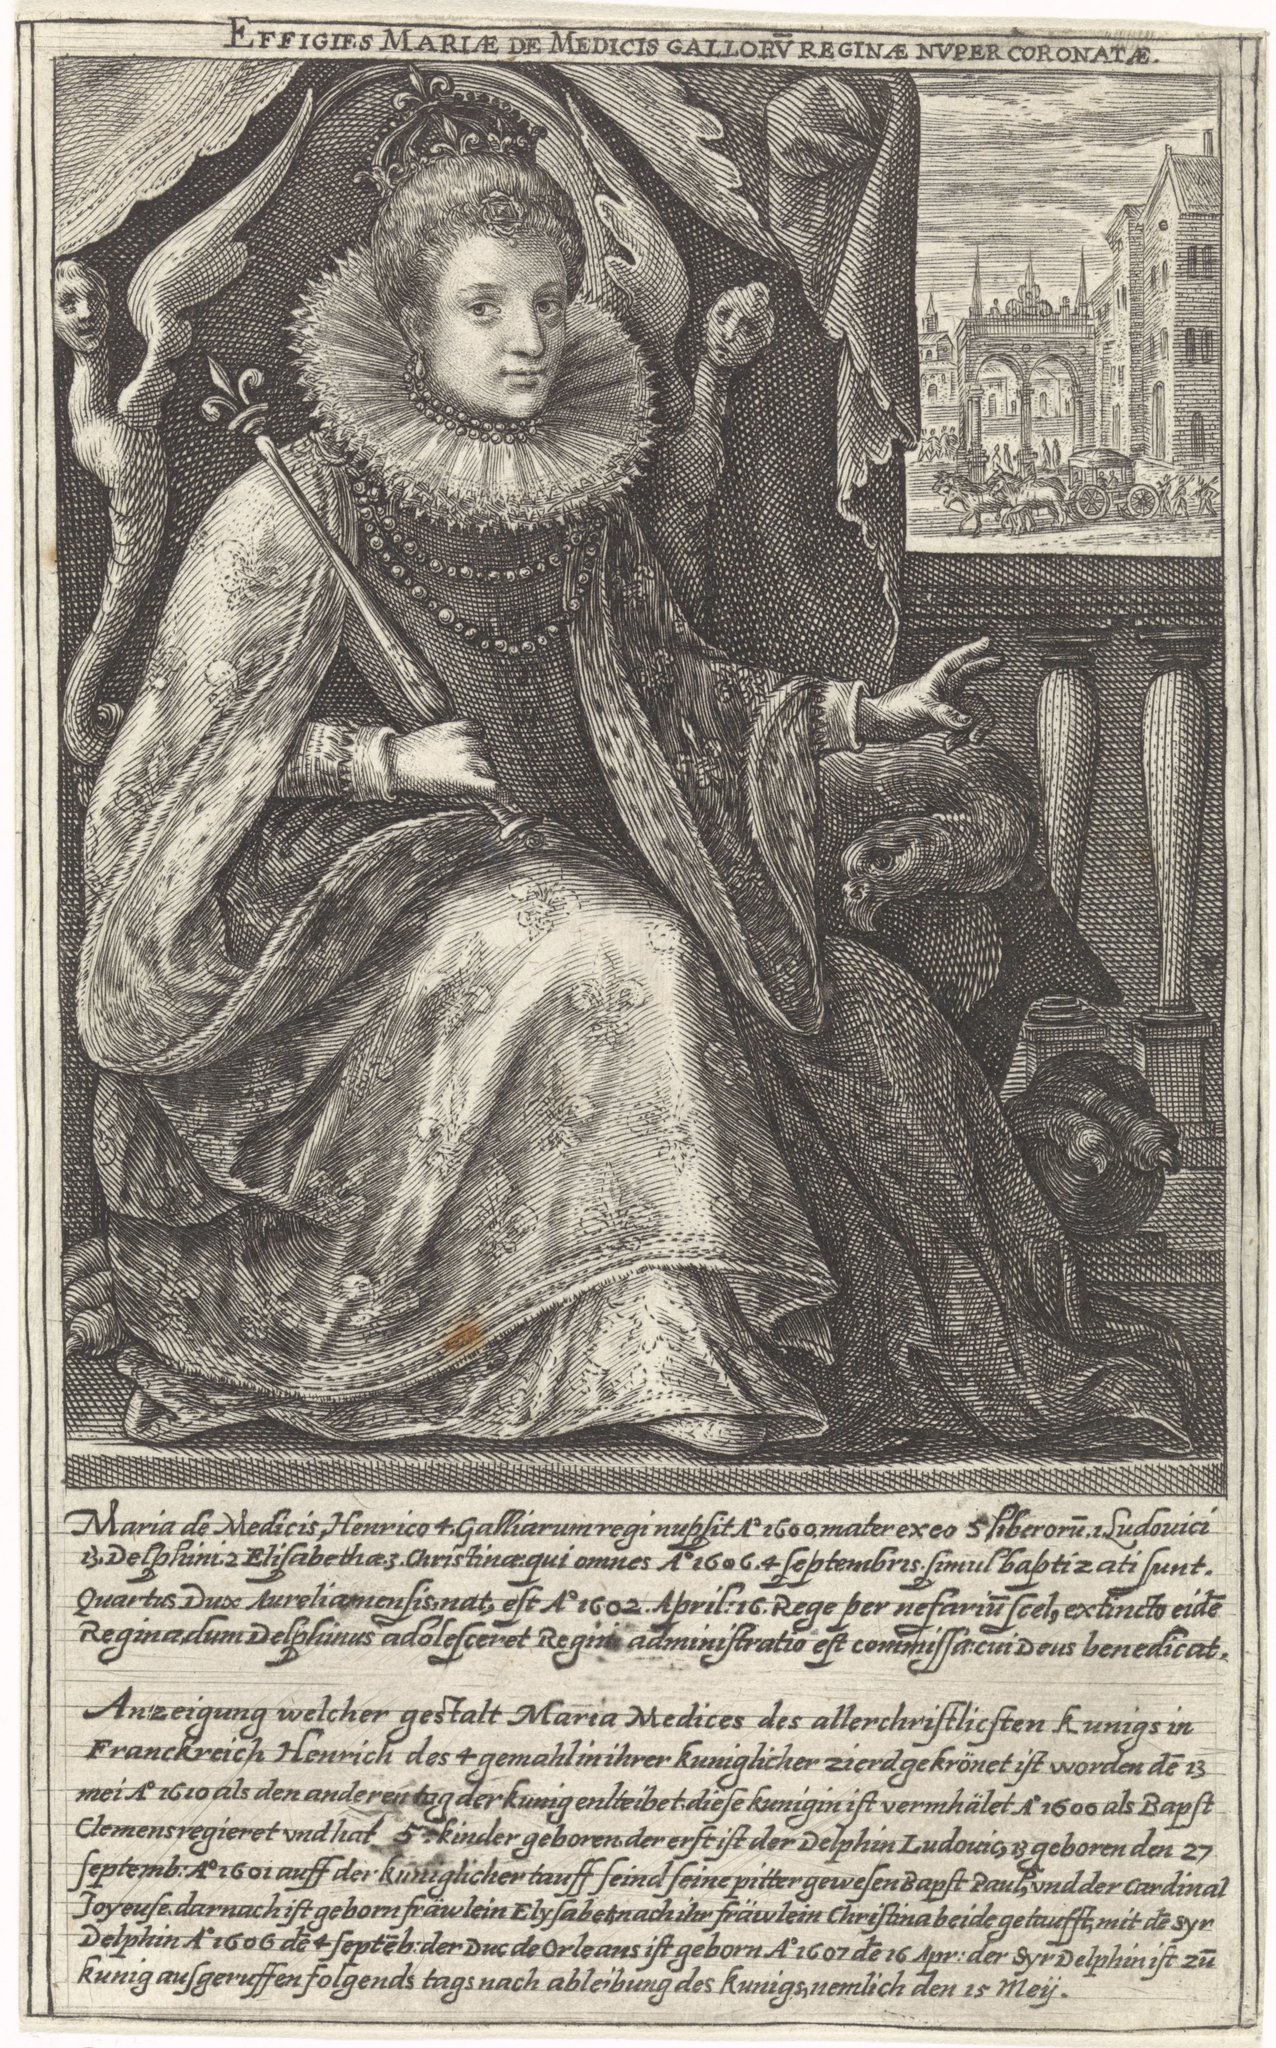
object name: print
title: Portret van Maria de' Medici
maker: crispijn van de passe (i)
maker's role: draughtsman, print maker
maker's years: 1564-1637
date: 1610-1637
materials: paper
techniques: engraving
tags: maria de' medici, chariot, triumphal car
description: Portret van Maria de' Medici, koningin van Frankrijk. Ze zit op een troon en maakt een zegenend gebaar met haar linkerhand. Op de achtergrond de intocht van Maria de' Medici. In de marge een vierregelig onderschrift in het Latijn en een achtregelig onderschrift in het Duits dat verwijst naar haar huwelijk en haar kinderen. Pendant van een portret van Lodewijk XIII.